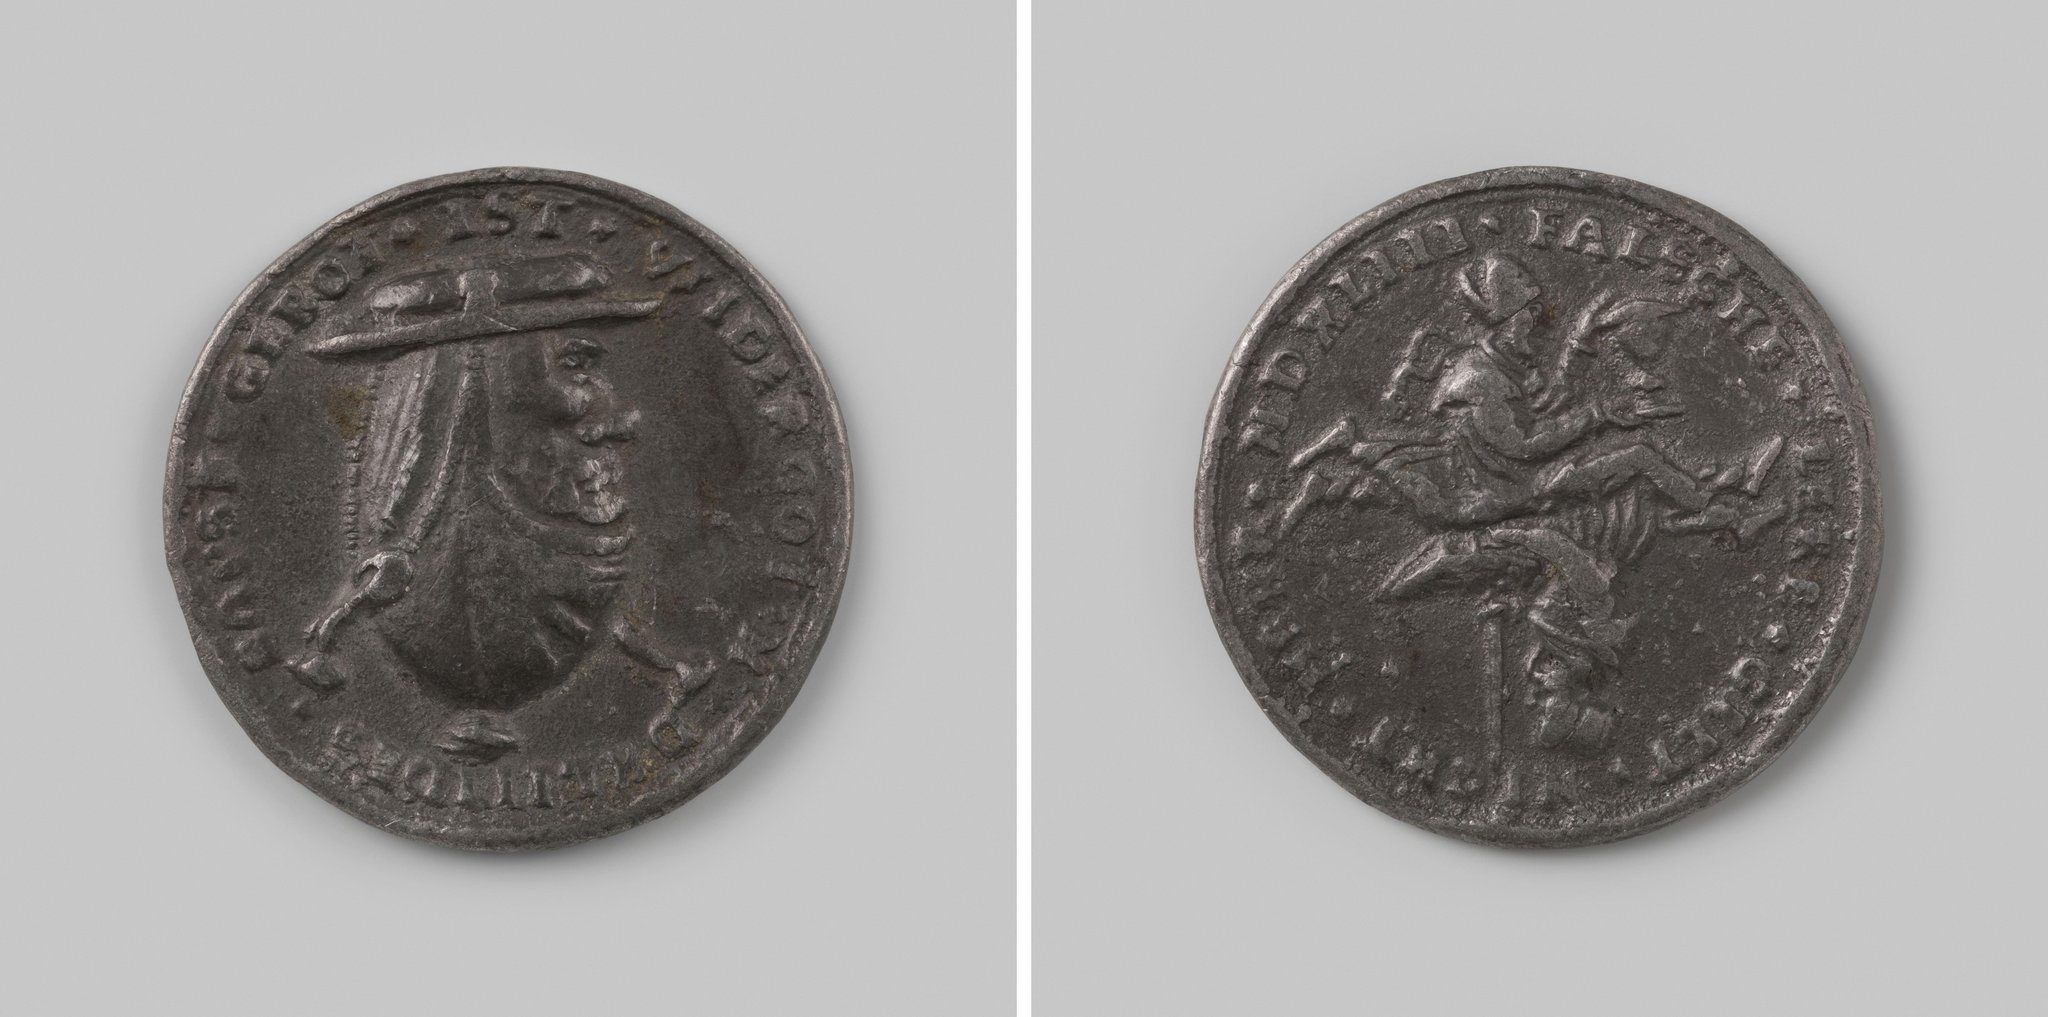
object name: history medal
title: Spotpenning op de Rooms-katholieke clerus 1543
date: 1543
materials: tin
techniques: casting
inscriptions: circumscription: ‘DES PAPST GEBOT IST WIDER GOT M DXLIII’, circumscription: ‘FALSCHE LERE GILT NICHT MEHR MDXLIII’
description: Tinnen penning, op de voorzijde het borstbeeld van een kardinaal draaibaar tot dat van een nar, met omschrift, op de keerzijde een geestelijke met een kelk draaibaar tot een vrouw met zwaard en boek, met omschrift.